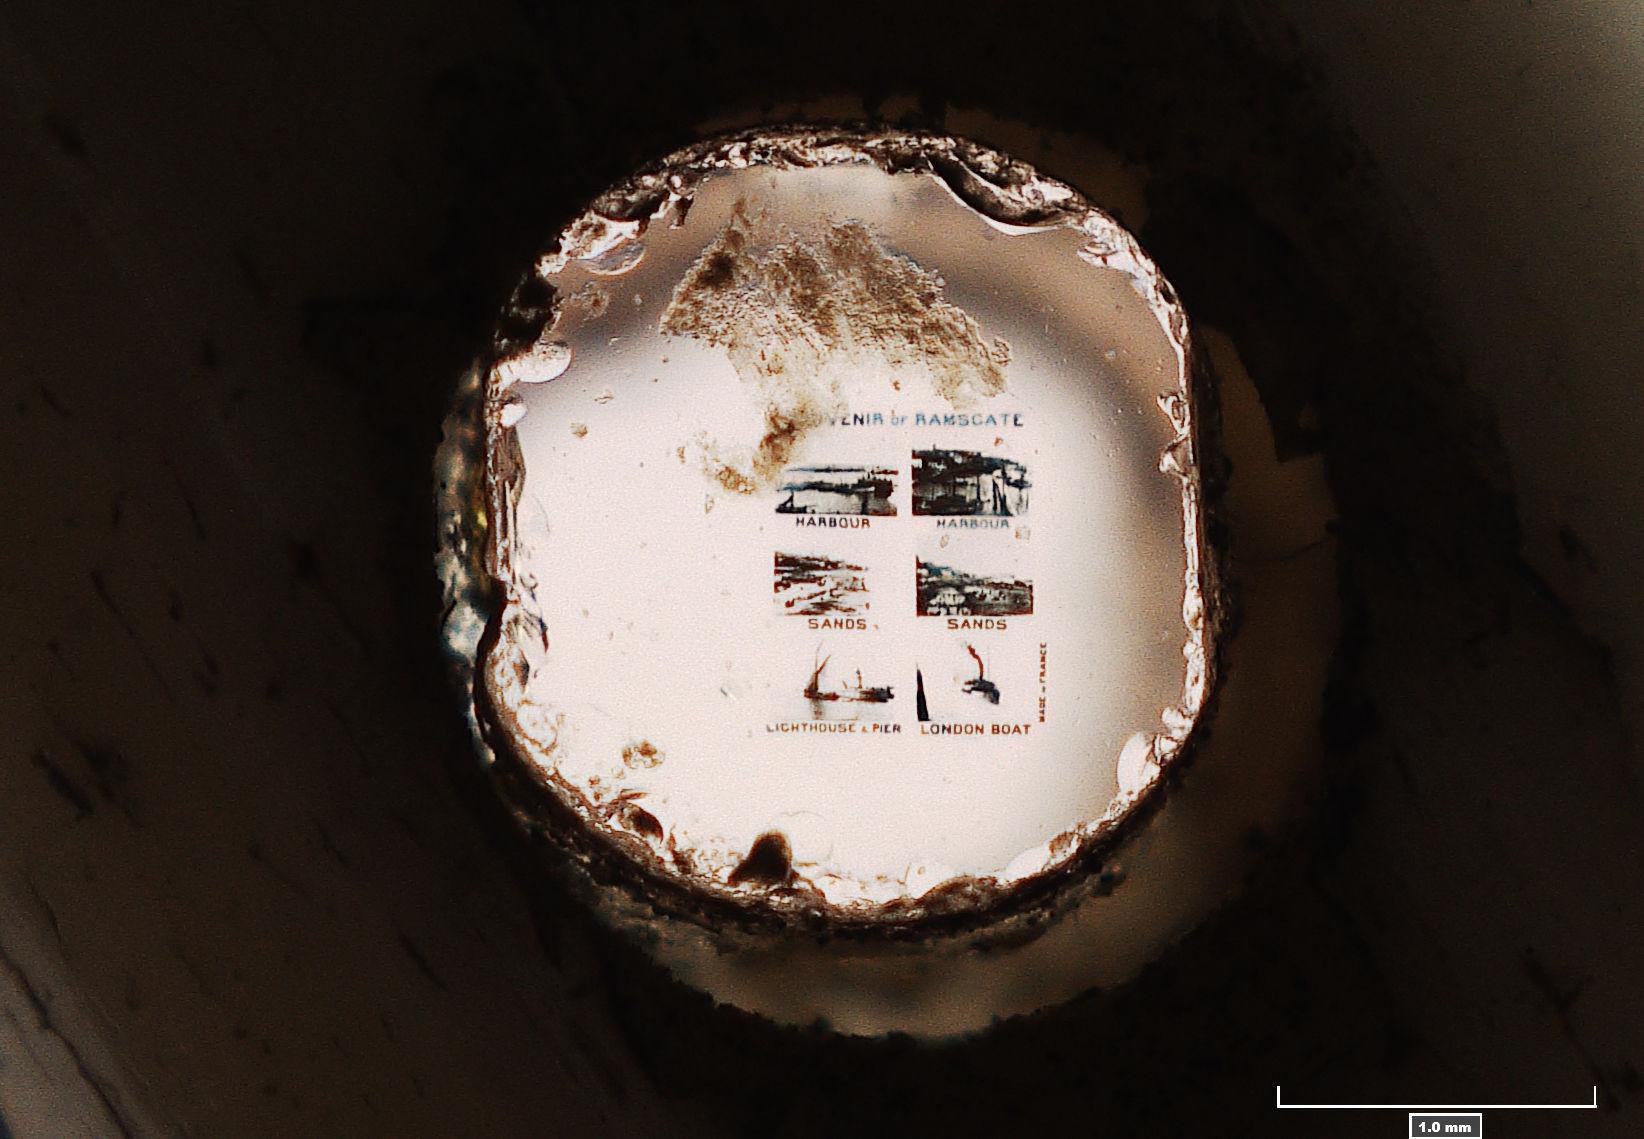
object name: collage visual work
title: Souvenir of Ramsgate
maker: Anonymous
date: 1857-1930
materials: bone, glass, metal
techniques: collodion process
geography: france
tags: harbour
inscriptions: inscription: ‘HARBOUR/ HARBOUR/ SANDS/ SANDS/ LIGHTHOUSE & PIER/ LONDON BOAT’